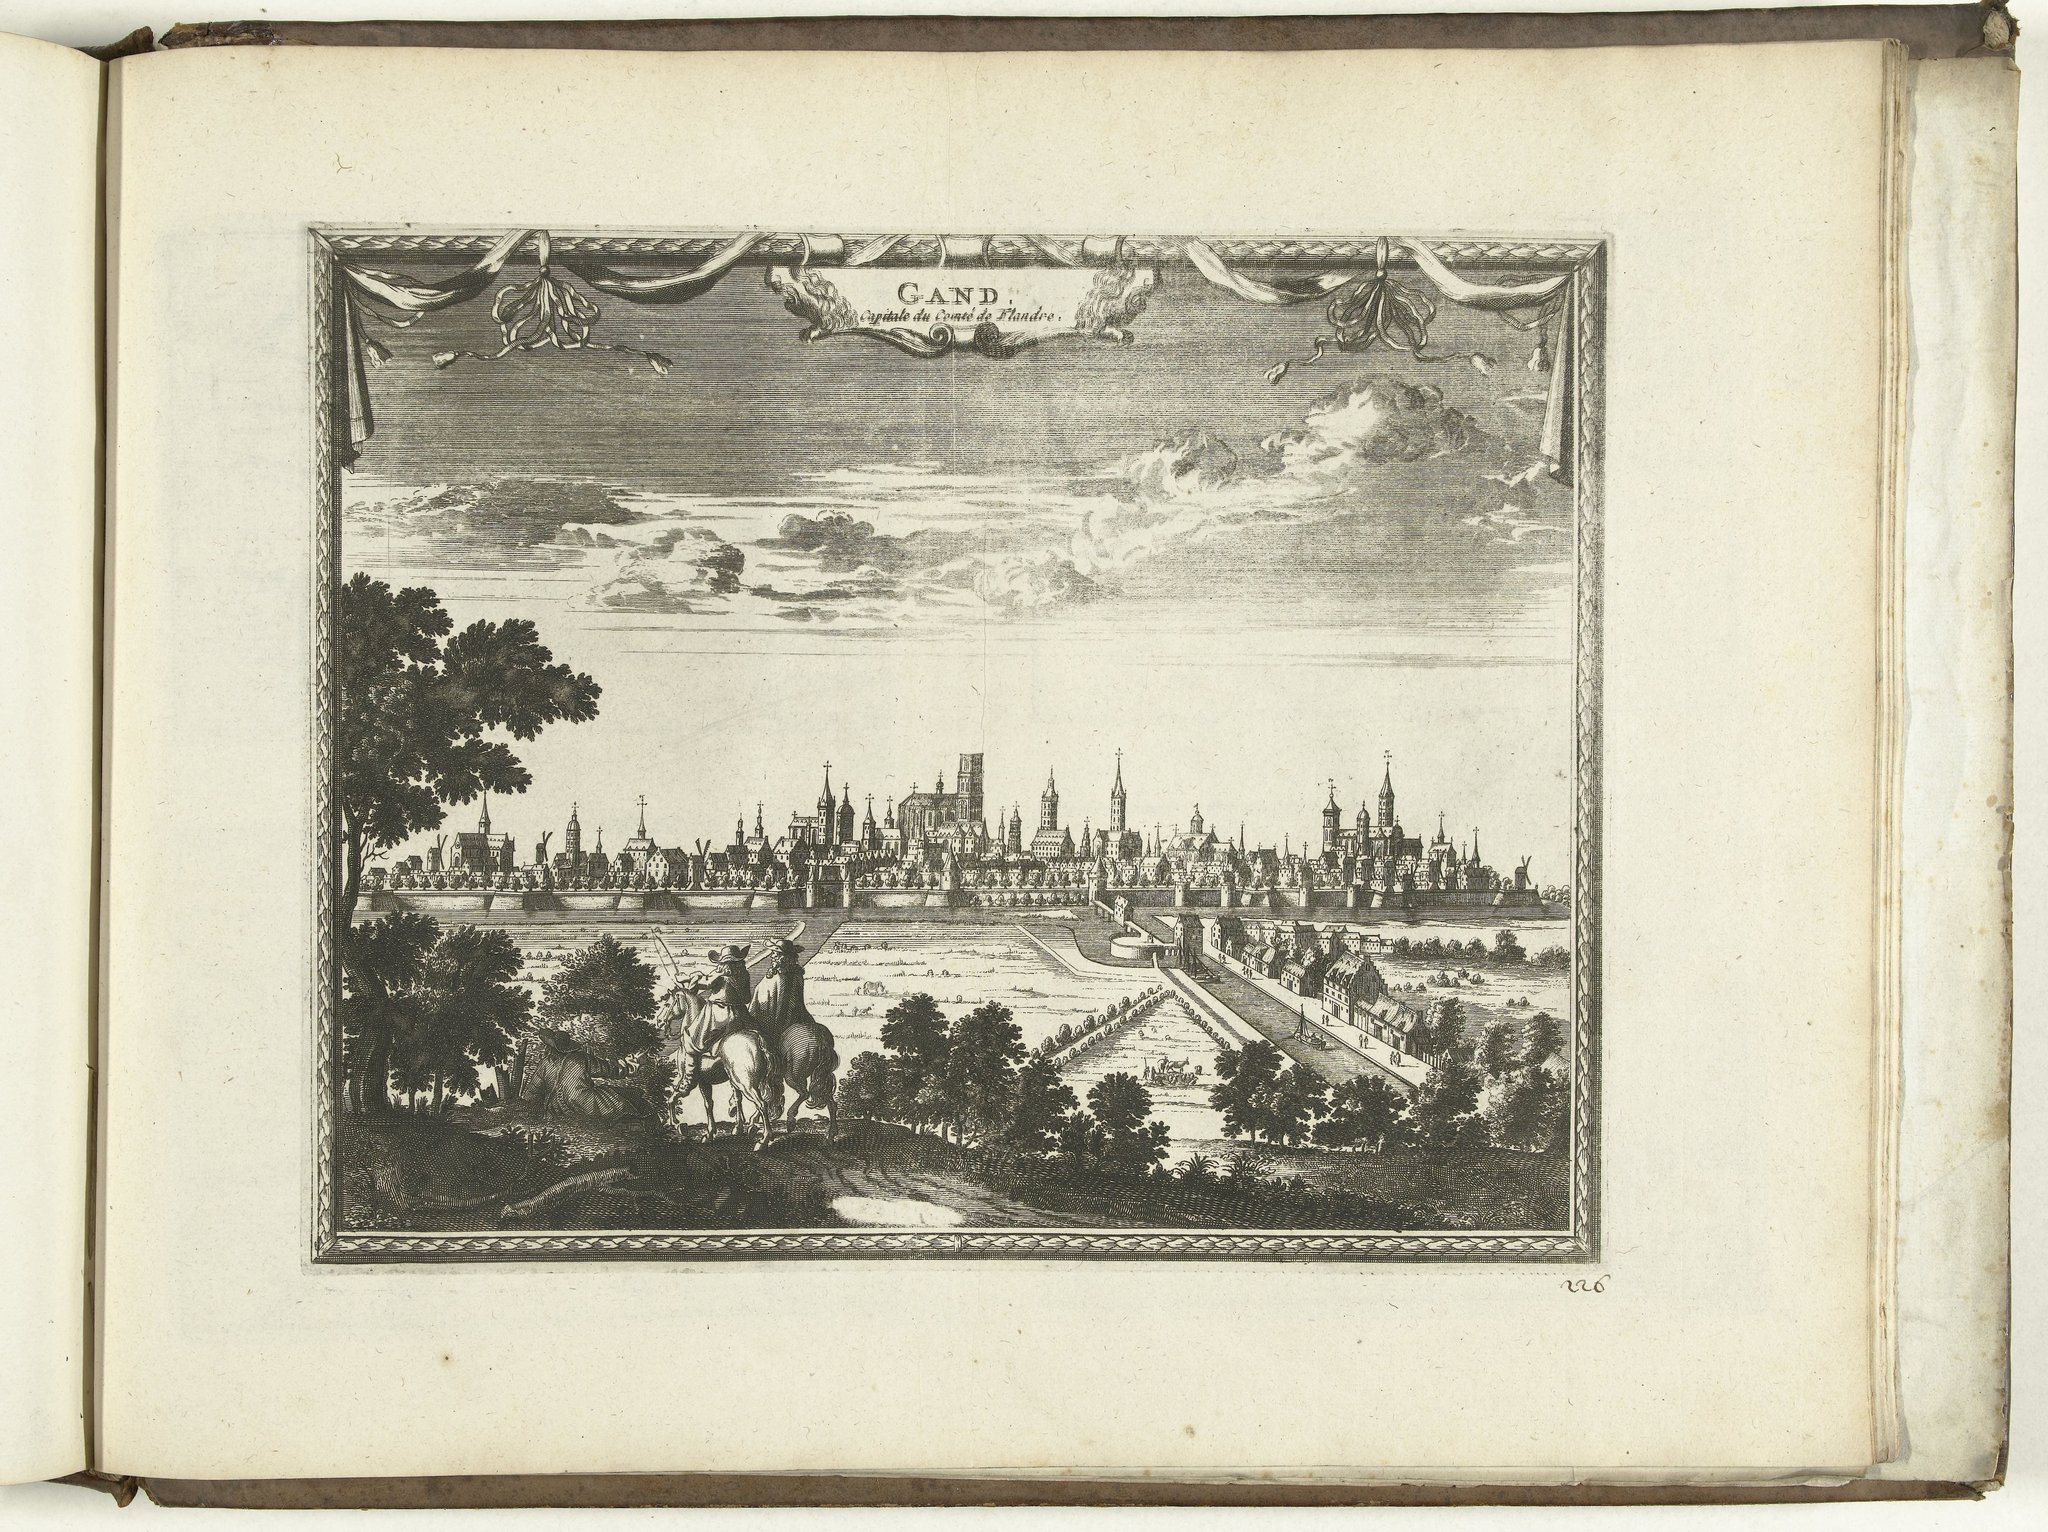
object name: print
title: Les Forces de l'Europe, Asie, Afrique et Amerique (...) Comme aussi les Cartes des Côtes de France et d'Espagne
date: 1726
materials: paper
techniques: etching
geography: northern netherlands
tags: ghent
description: Gezicht op Gent, op de voorgrond twee ruiters. Plaat nr. 226 in deel X van het prentwerk: Les Forces de l'Europe, Asie, Afrique et Amerique ... Comme aussi les Cartes des Côtes de France et d'Espagne uit 1726, dit eerste deel met 238 met de hand genummerde platen van vermaarde sterke steden en vestingen in het kader van de Spaanse Successieoorlog 1701-1713. Voor het merendeel zijn deze platen gekopieerd naar de anonieme Franse platen van vermaarde sterke steden en vestingen: in Les forces de l'Europe en in: Le theatre de la guerre, dans les Pays-Bas, beide oorspronkelijk uitgegeven door Nicolas de Fer te Parijs (1693-1697) in het kader van de Negenjarige Oorlog. Titel in het Frans.